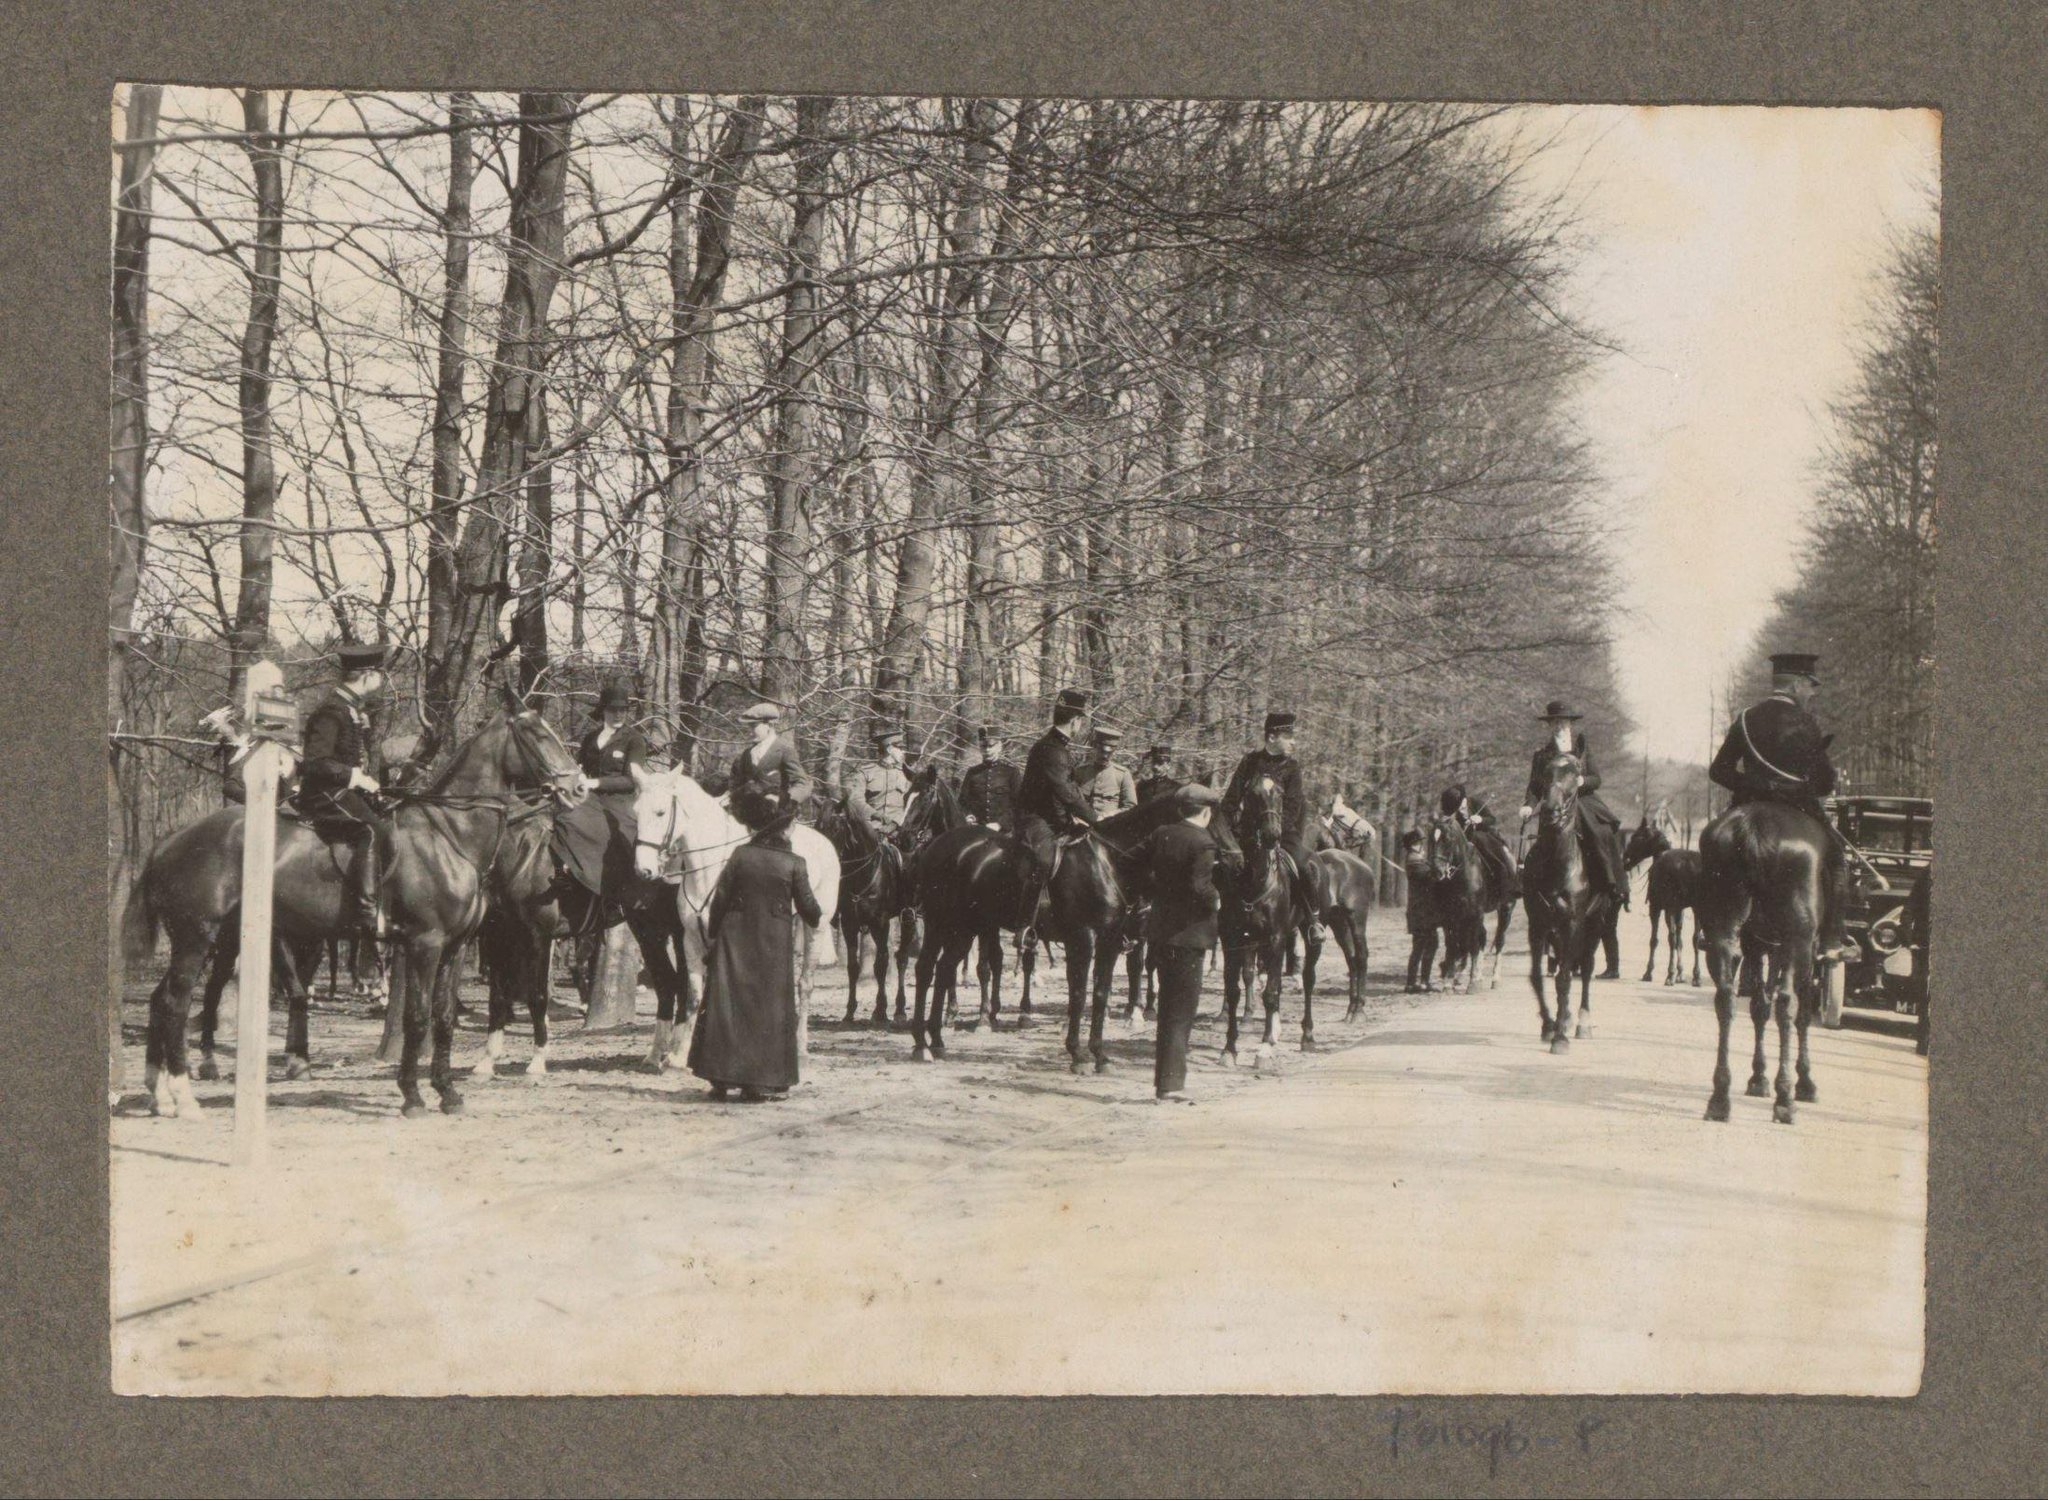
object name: photograph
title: Ruitertafereel op Koninklijke Houtvesterij Het Loo: ruiters met publiek op een landweg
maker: Anonymous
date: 1900-1925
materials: photographic support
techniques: gelatin silver print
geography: het loo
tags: riding a horse, ass, or mule; rider, horseman, hunting, chase, hunting-ground, forest path or lane, automobile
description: Onderdeel van Fotoalbum van de heer Brams, opperhoutvester van koningin Wilhelmina op Koninklijke Houtvesterij Het Loo.